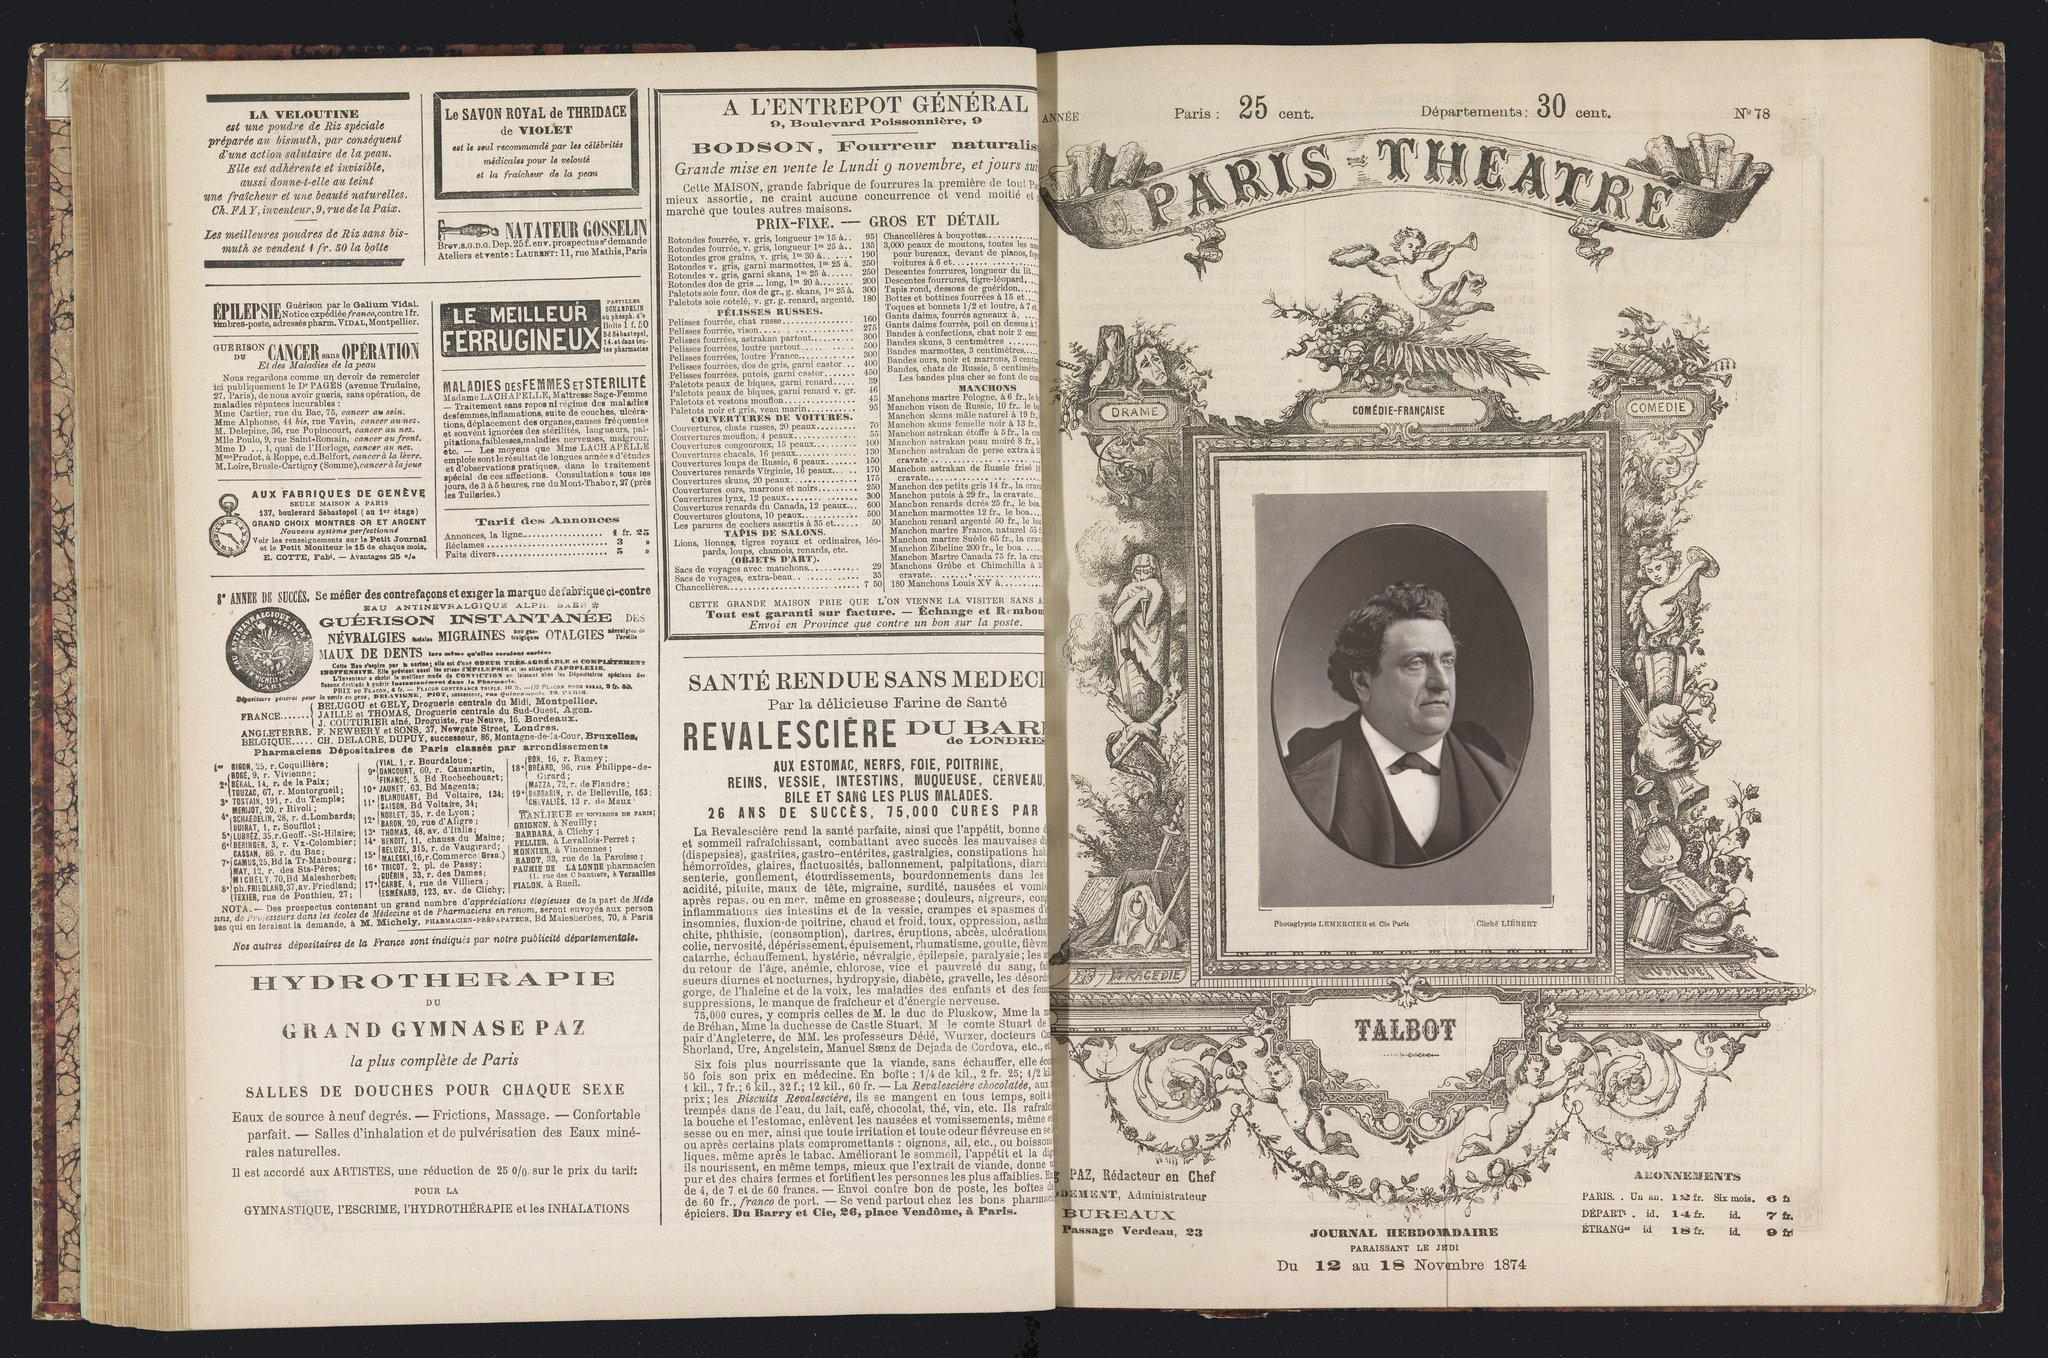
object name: page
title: Portret van Talbot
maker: alphonse-justin liébert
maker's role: fotograaf, marinier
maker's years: 1827-1914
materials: paper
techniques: woodburytype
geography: paris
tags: portrait of actor, actress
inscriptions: inscription: ‘Journal hebdomadaire paraissant le jeudi Du 12 au 18 Novembre 1874’, number: ‘No 78’